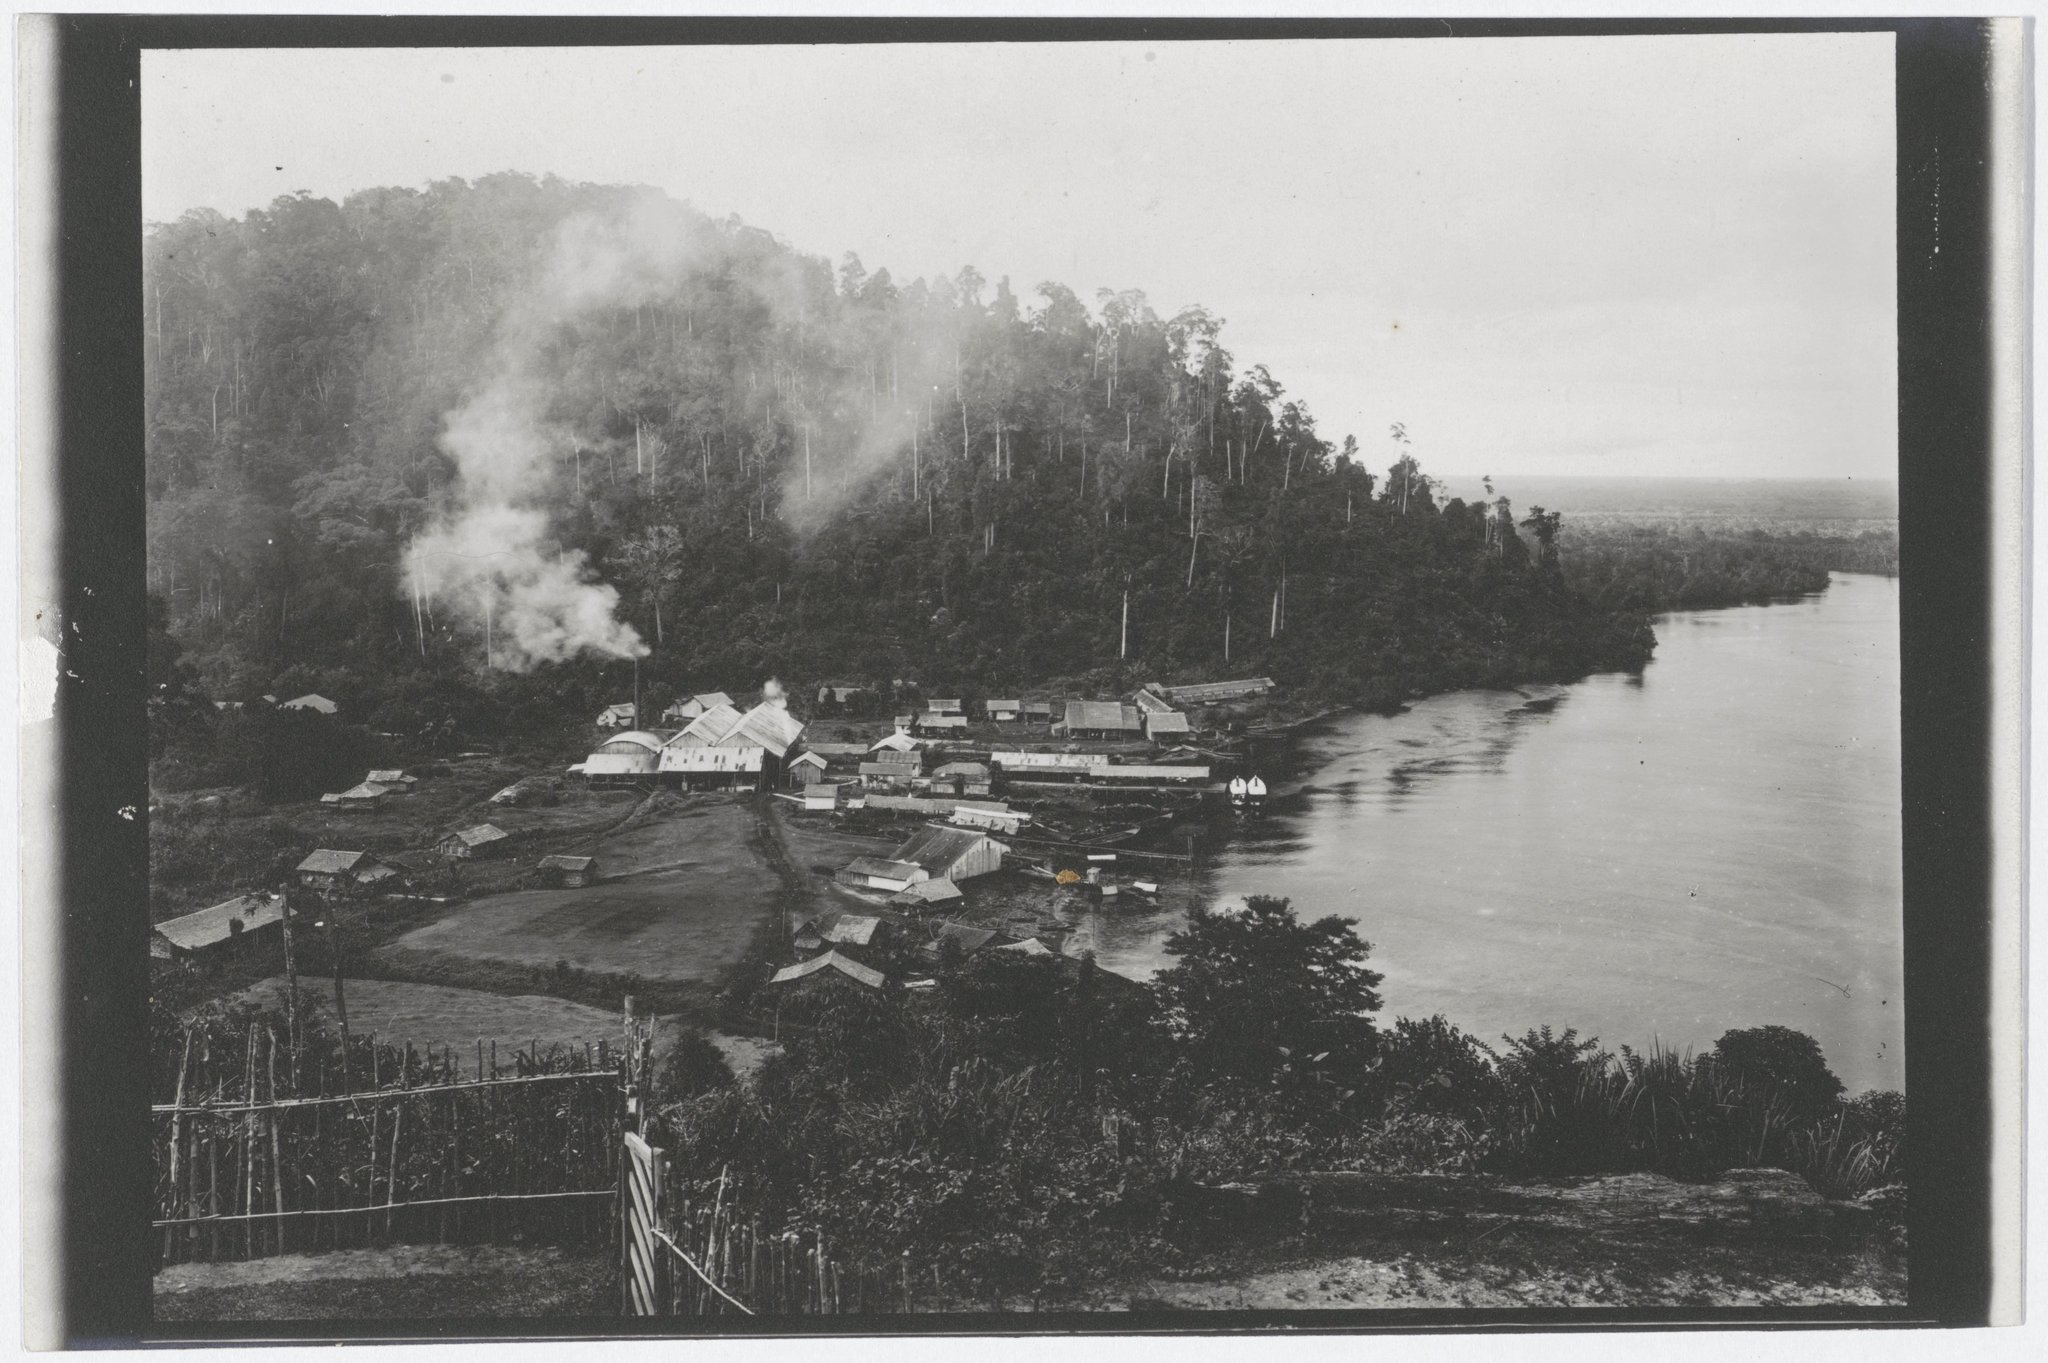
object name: photograph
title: Een fabriek in Telok, gelegen aan het water.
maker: johanna hermina marmelstein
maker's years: 1897-1990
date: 1900-1915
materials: paper, photographic support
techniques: albumen print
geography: jakarta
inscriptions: inscription: ‘Ingang van een aanzienlijk huis. Tempeltje, logis voor de huisgoden, stenen deurwachters.’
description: Een fabriek in Telok, gelegen aan het water. De fabriek heeft vele bijgebouwen en enkele aangemeerde boten.